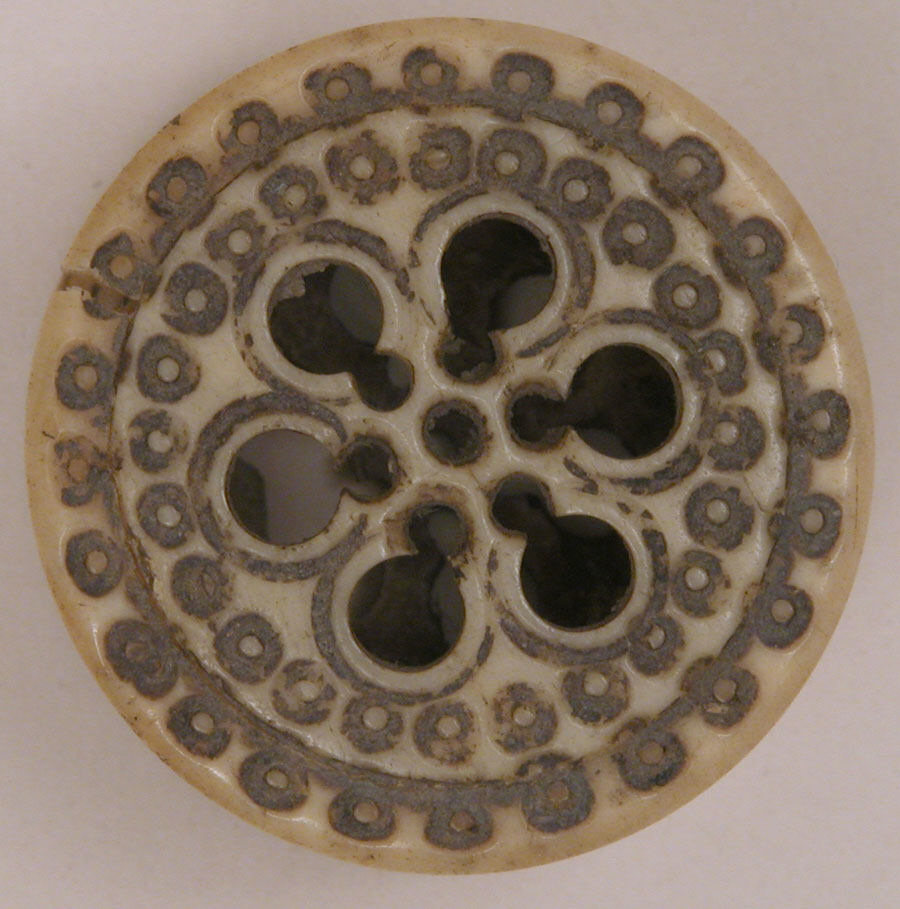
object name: spool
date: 201-1200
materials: bone, paint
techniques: incising, inlay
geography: egypt